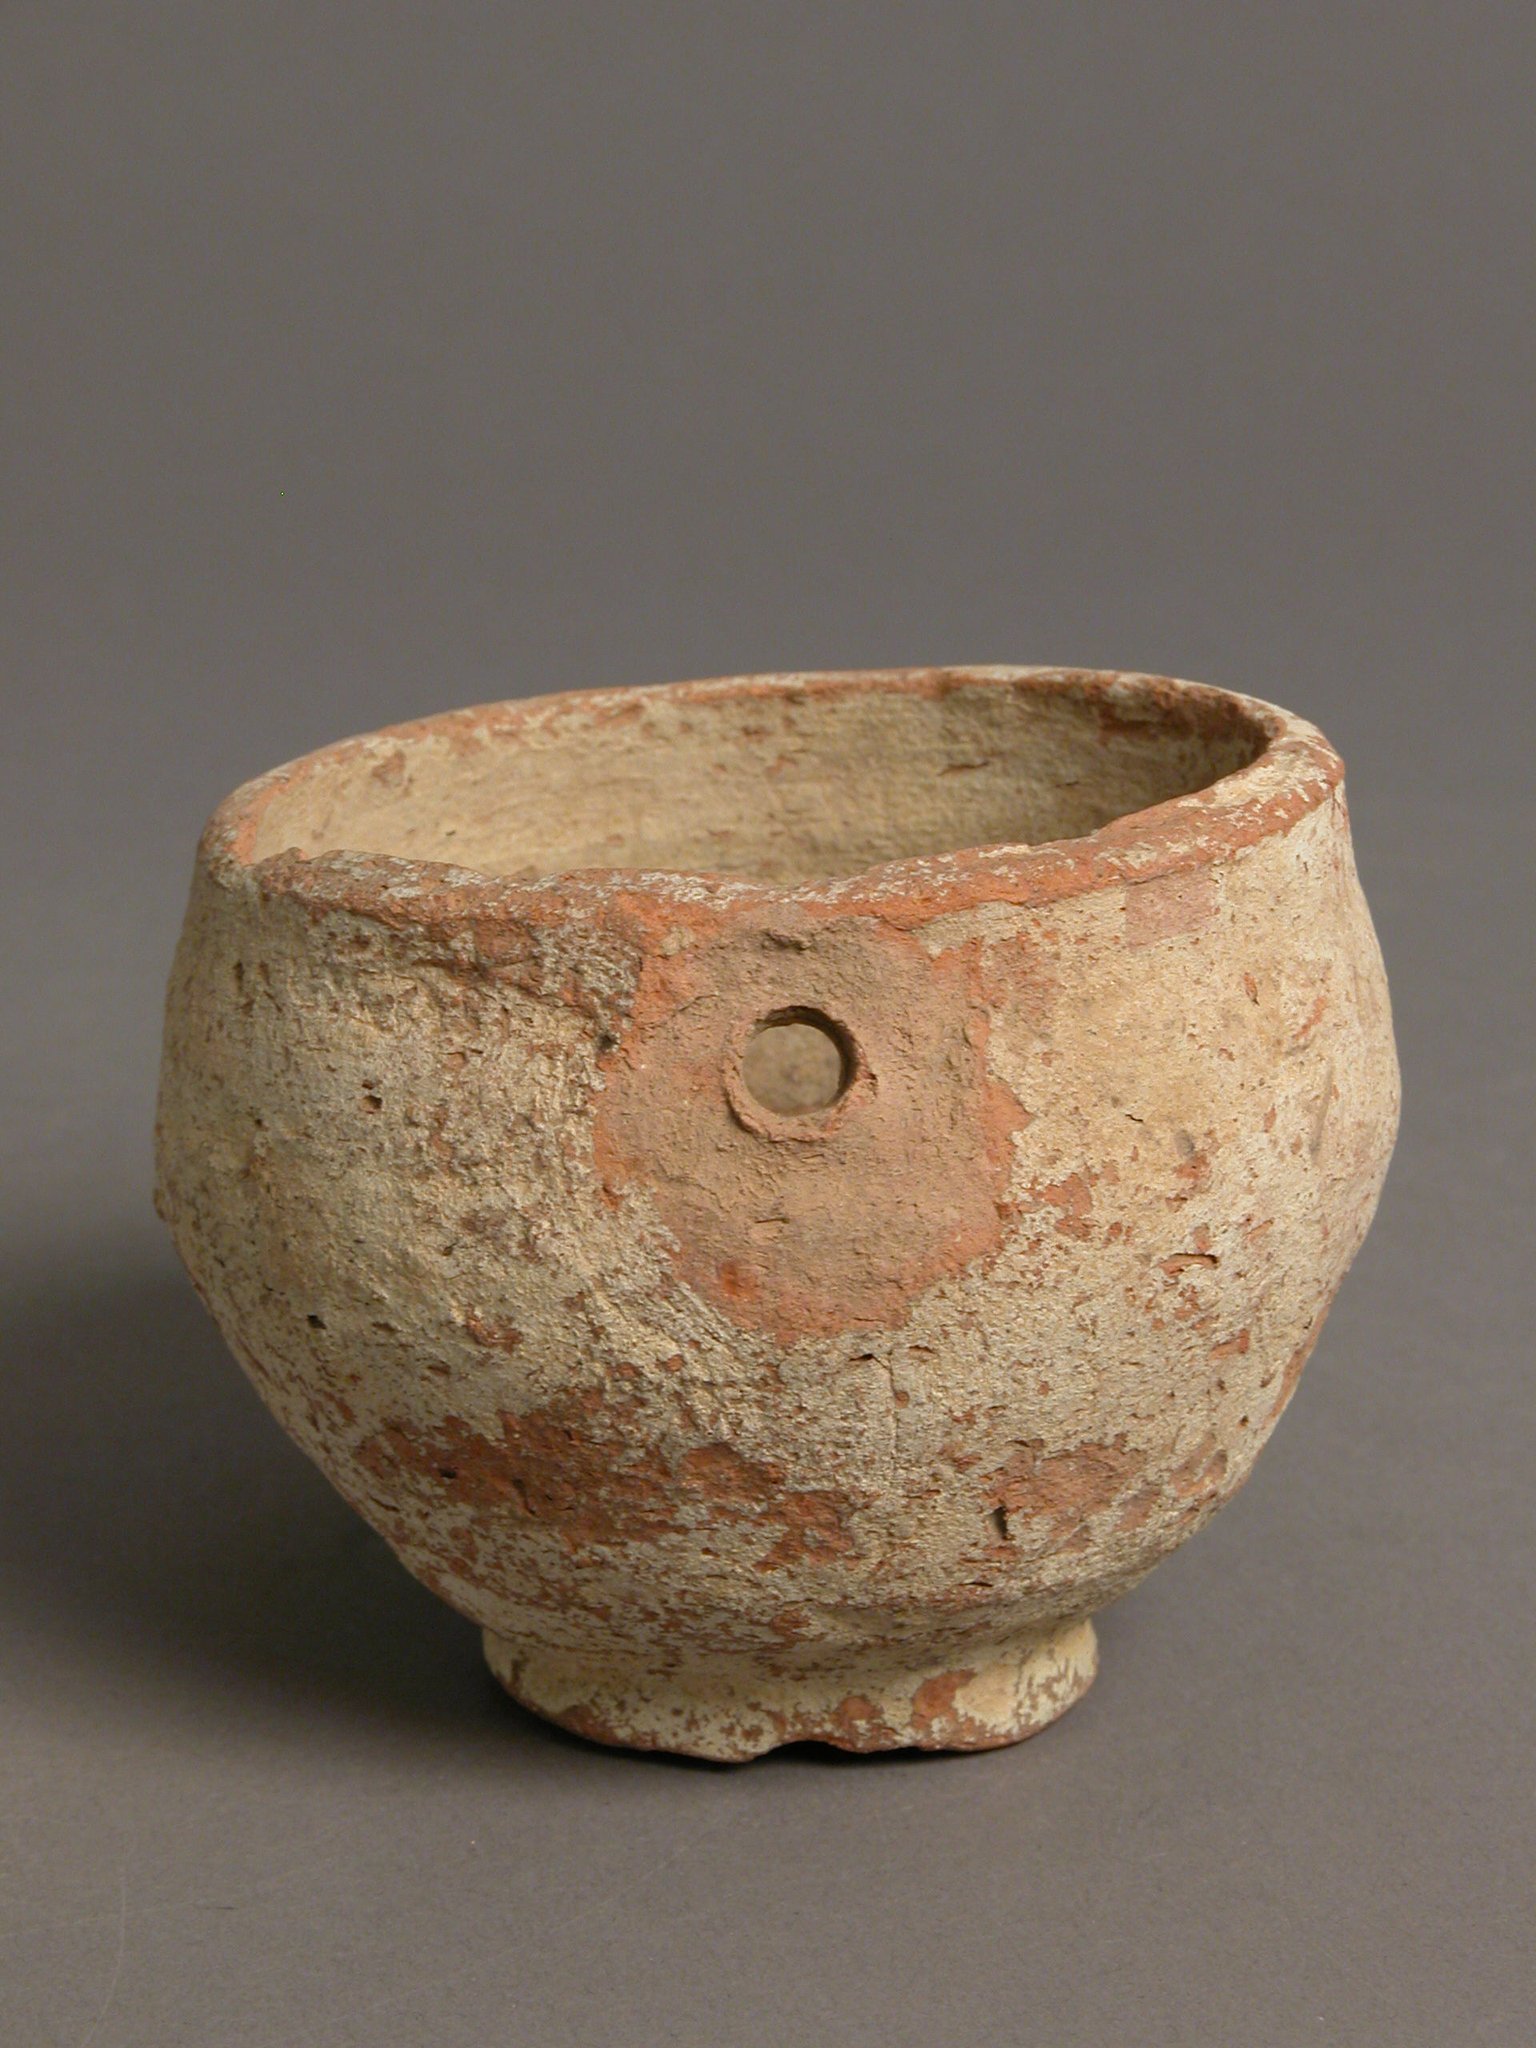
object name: cup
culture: coptic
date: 301-700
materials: earthenware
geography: egypt